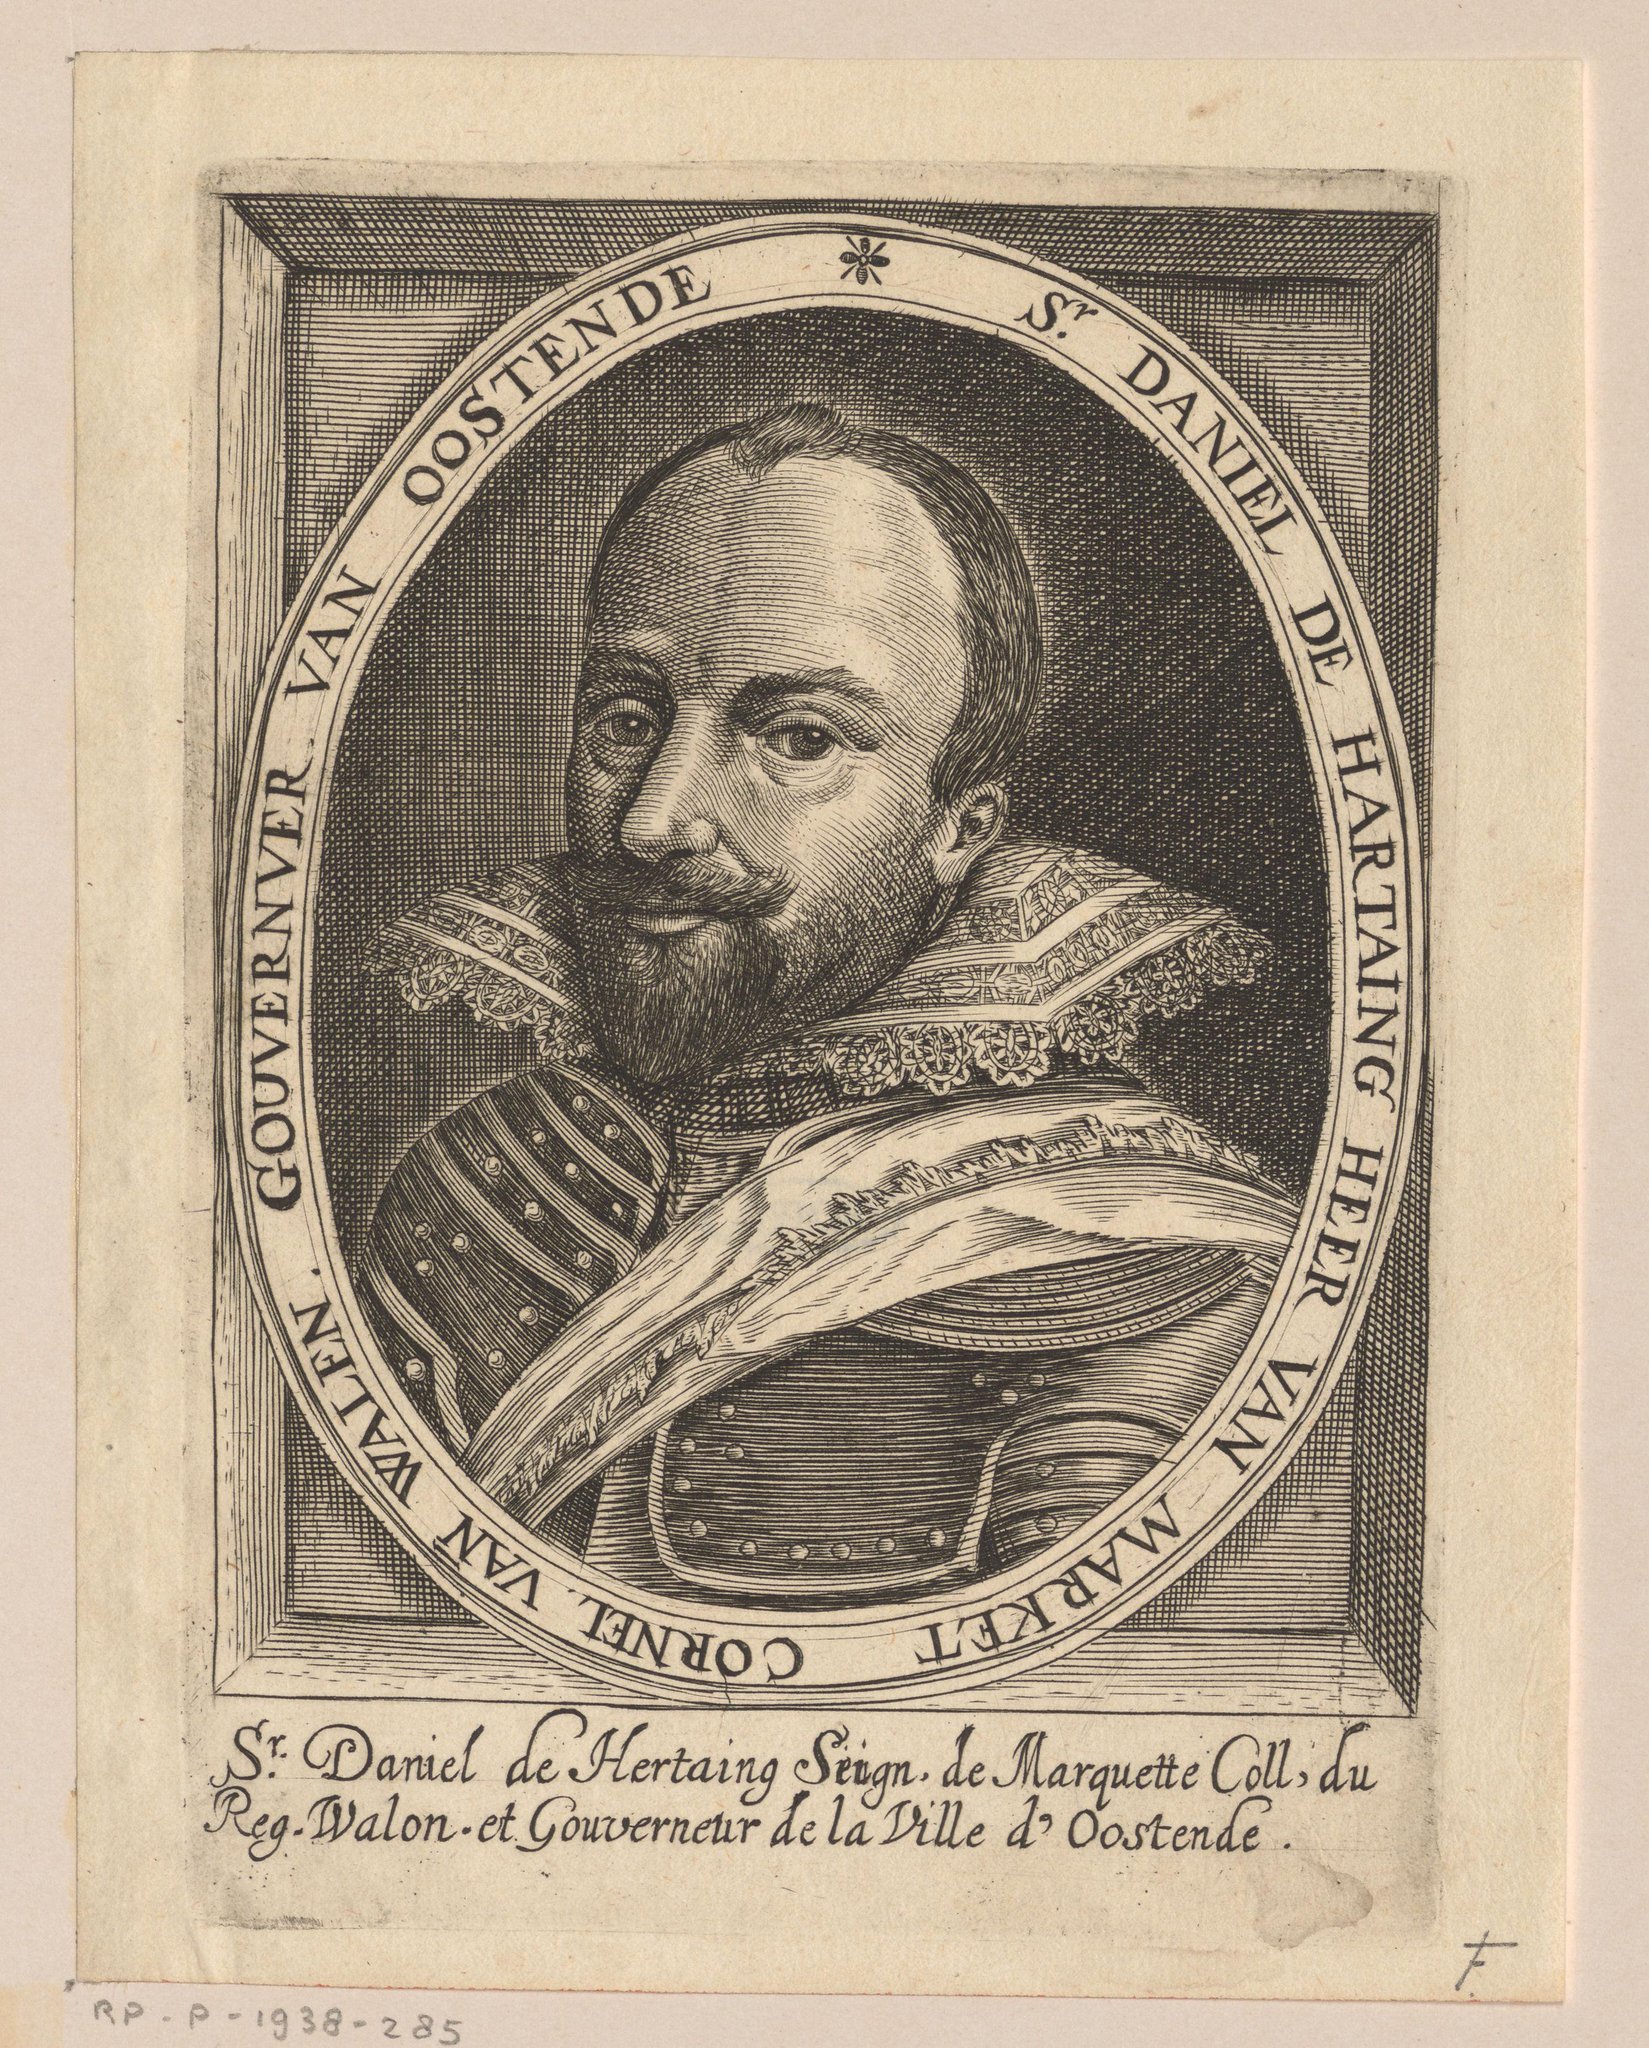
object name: book illustration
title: Portret van Daniel de Hartaing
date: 1621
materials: paper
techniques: engraving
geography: the hague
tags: commander-in-chief, general, marshal, armour, historical persons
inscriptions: collector's mark: Lugt 2228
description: Prent uit: Fleming, Philippe. Oostende vermaerde, gheweldighe, lanckduyrighe, ende bloedighe belegheringhe, bestorminghe ende stoute aenvallen (...). Den Haag: Aert Meuris, 1621.